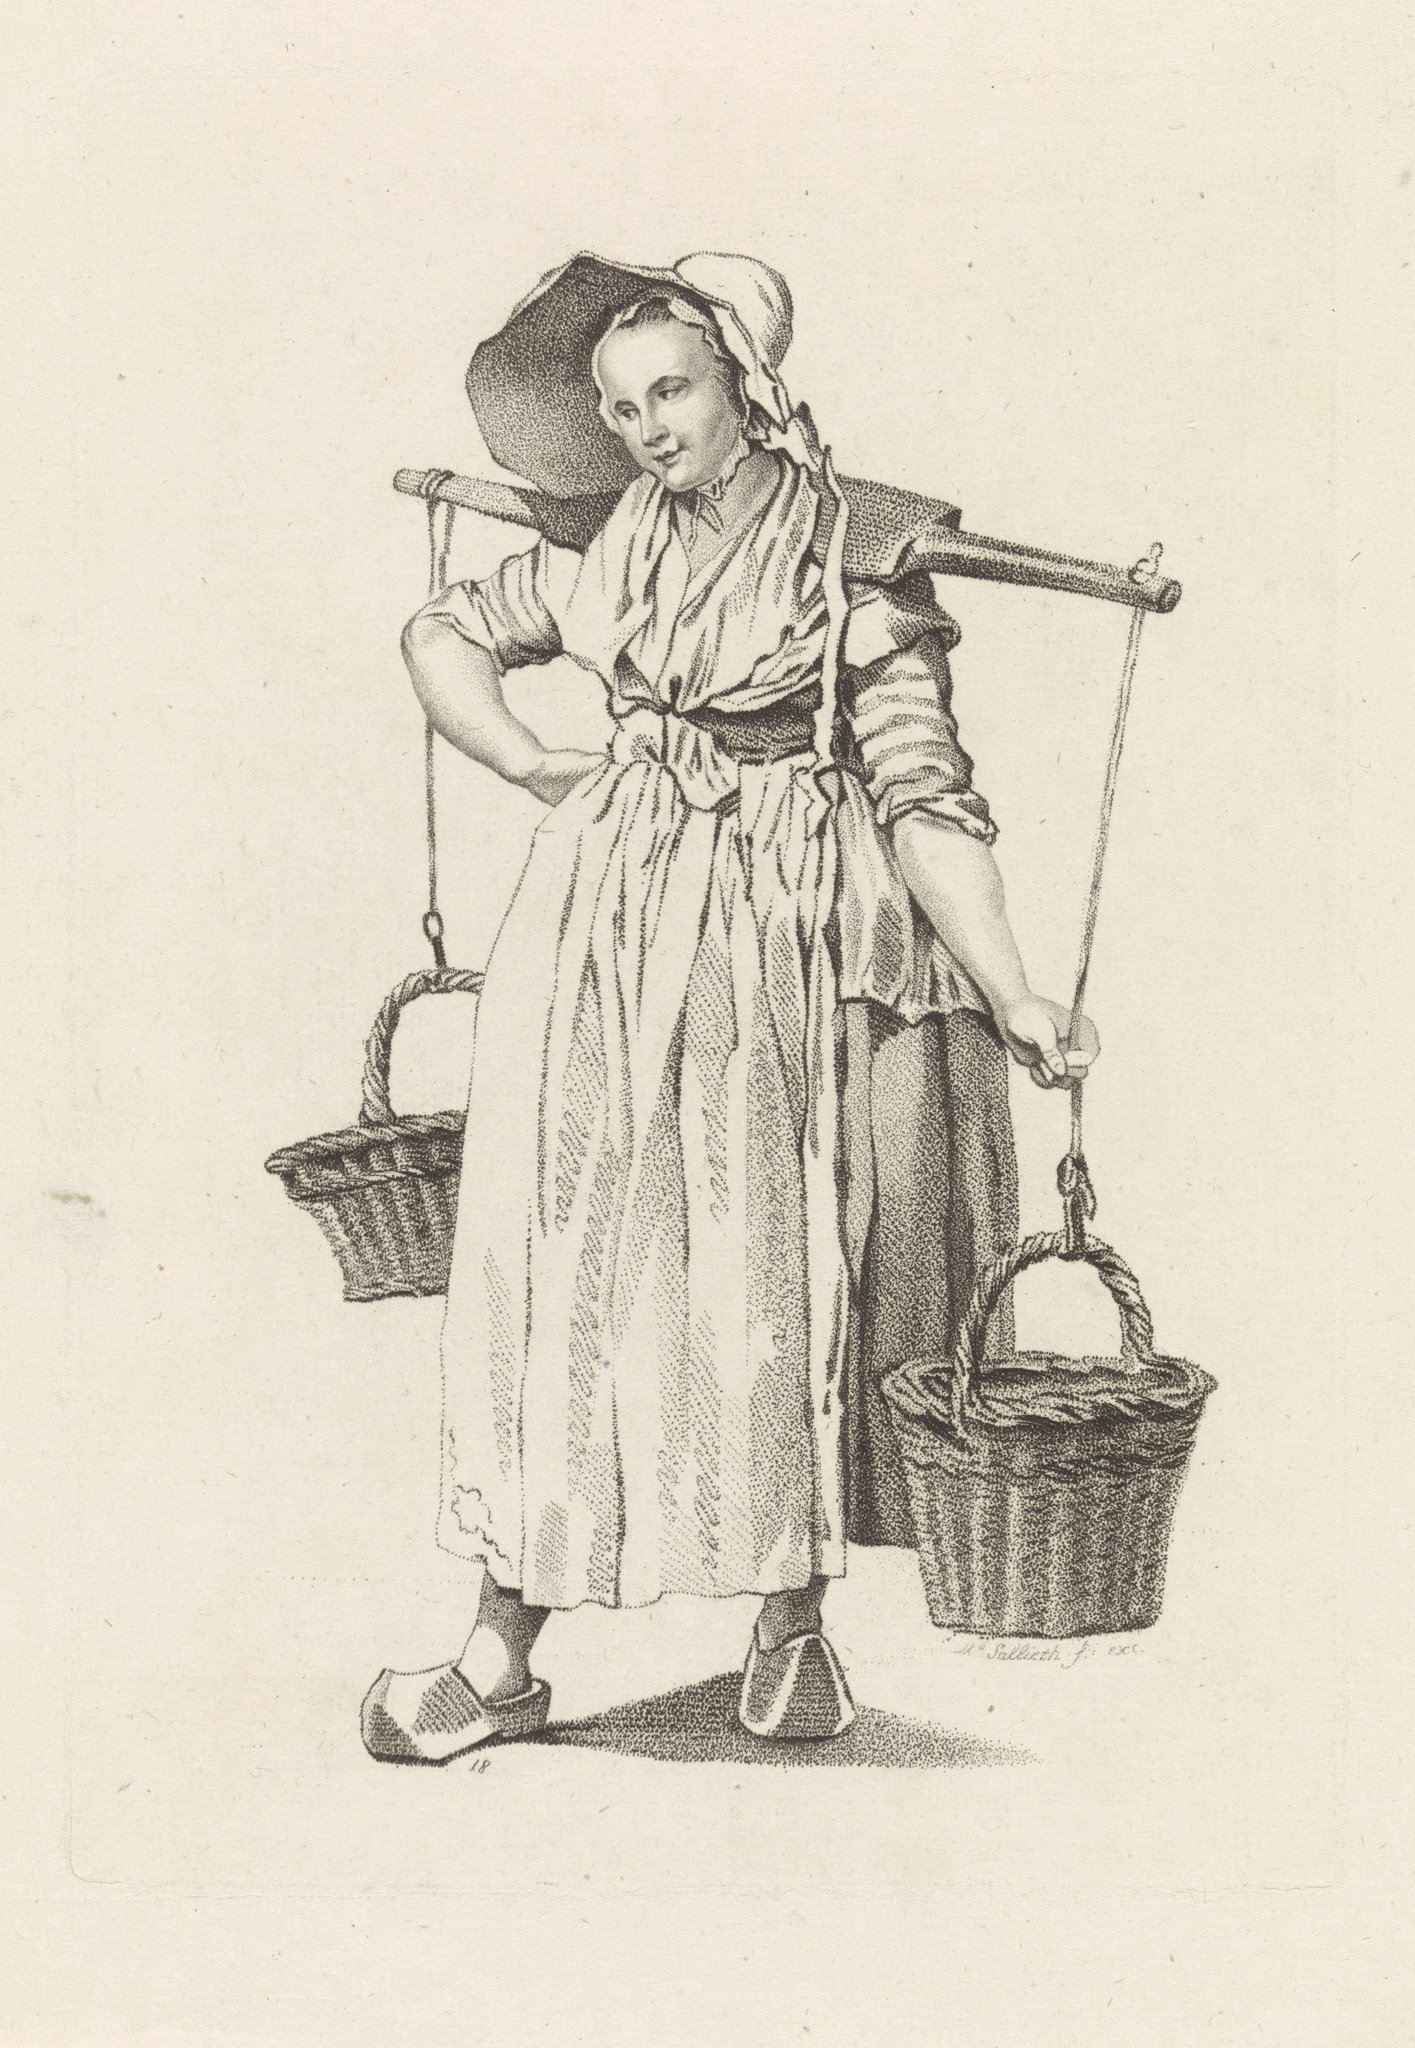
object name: print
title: Boerenvrouw met twee manden aan een juk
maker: mathias de sallieth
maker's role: print maker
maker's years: 1749-1791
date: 1772-1791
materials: paper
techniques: printmaking, etching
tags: farmers - aa - female farmer, farmer's wife, container made of plant material other than wood: basket, carrying something with yoke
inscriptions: collector's mark: Lugt 2166, collector's mark: Lugt 2760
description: De prent verscheen vanaf 1818 tevens als onderdeel van een 33-delige reeks prenten door Mathias de Sallieth, samengebonden in: Perkois, Jacobus, Prins, Johannes Huibert. Verzameling van verschillende gekleede mans- en vrouwenstanden, ter oefening van jonge schilders en liefhebbers. Rotterdam: Johannes Immerzeel, 1818.